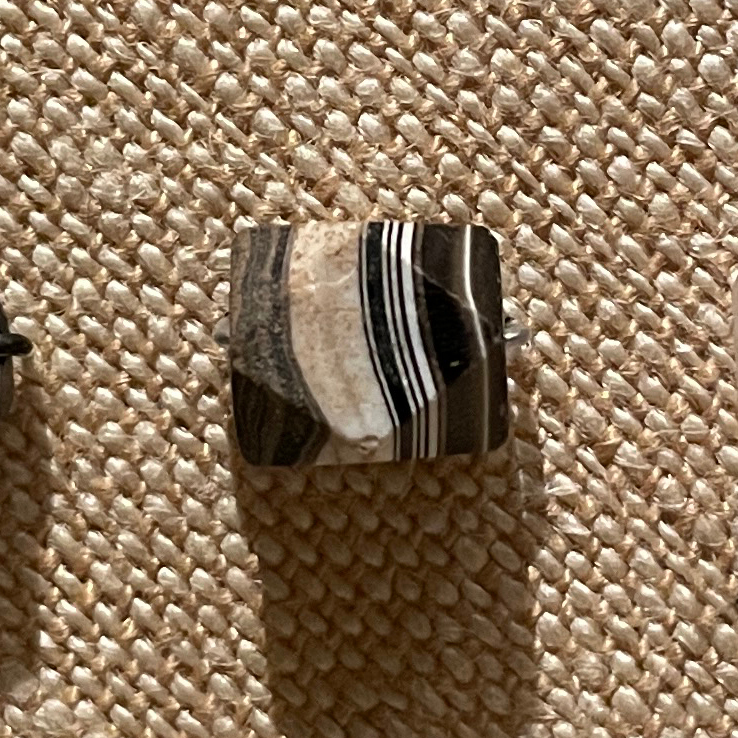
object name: bead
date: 801-1100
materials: onyx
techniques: cutting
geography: iran